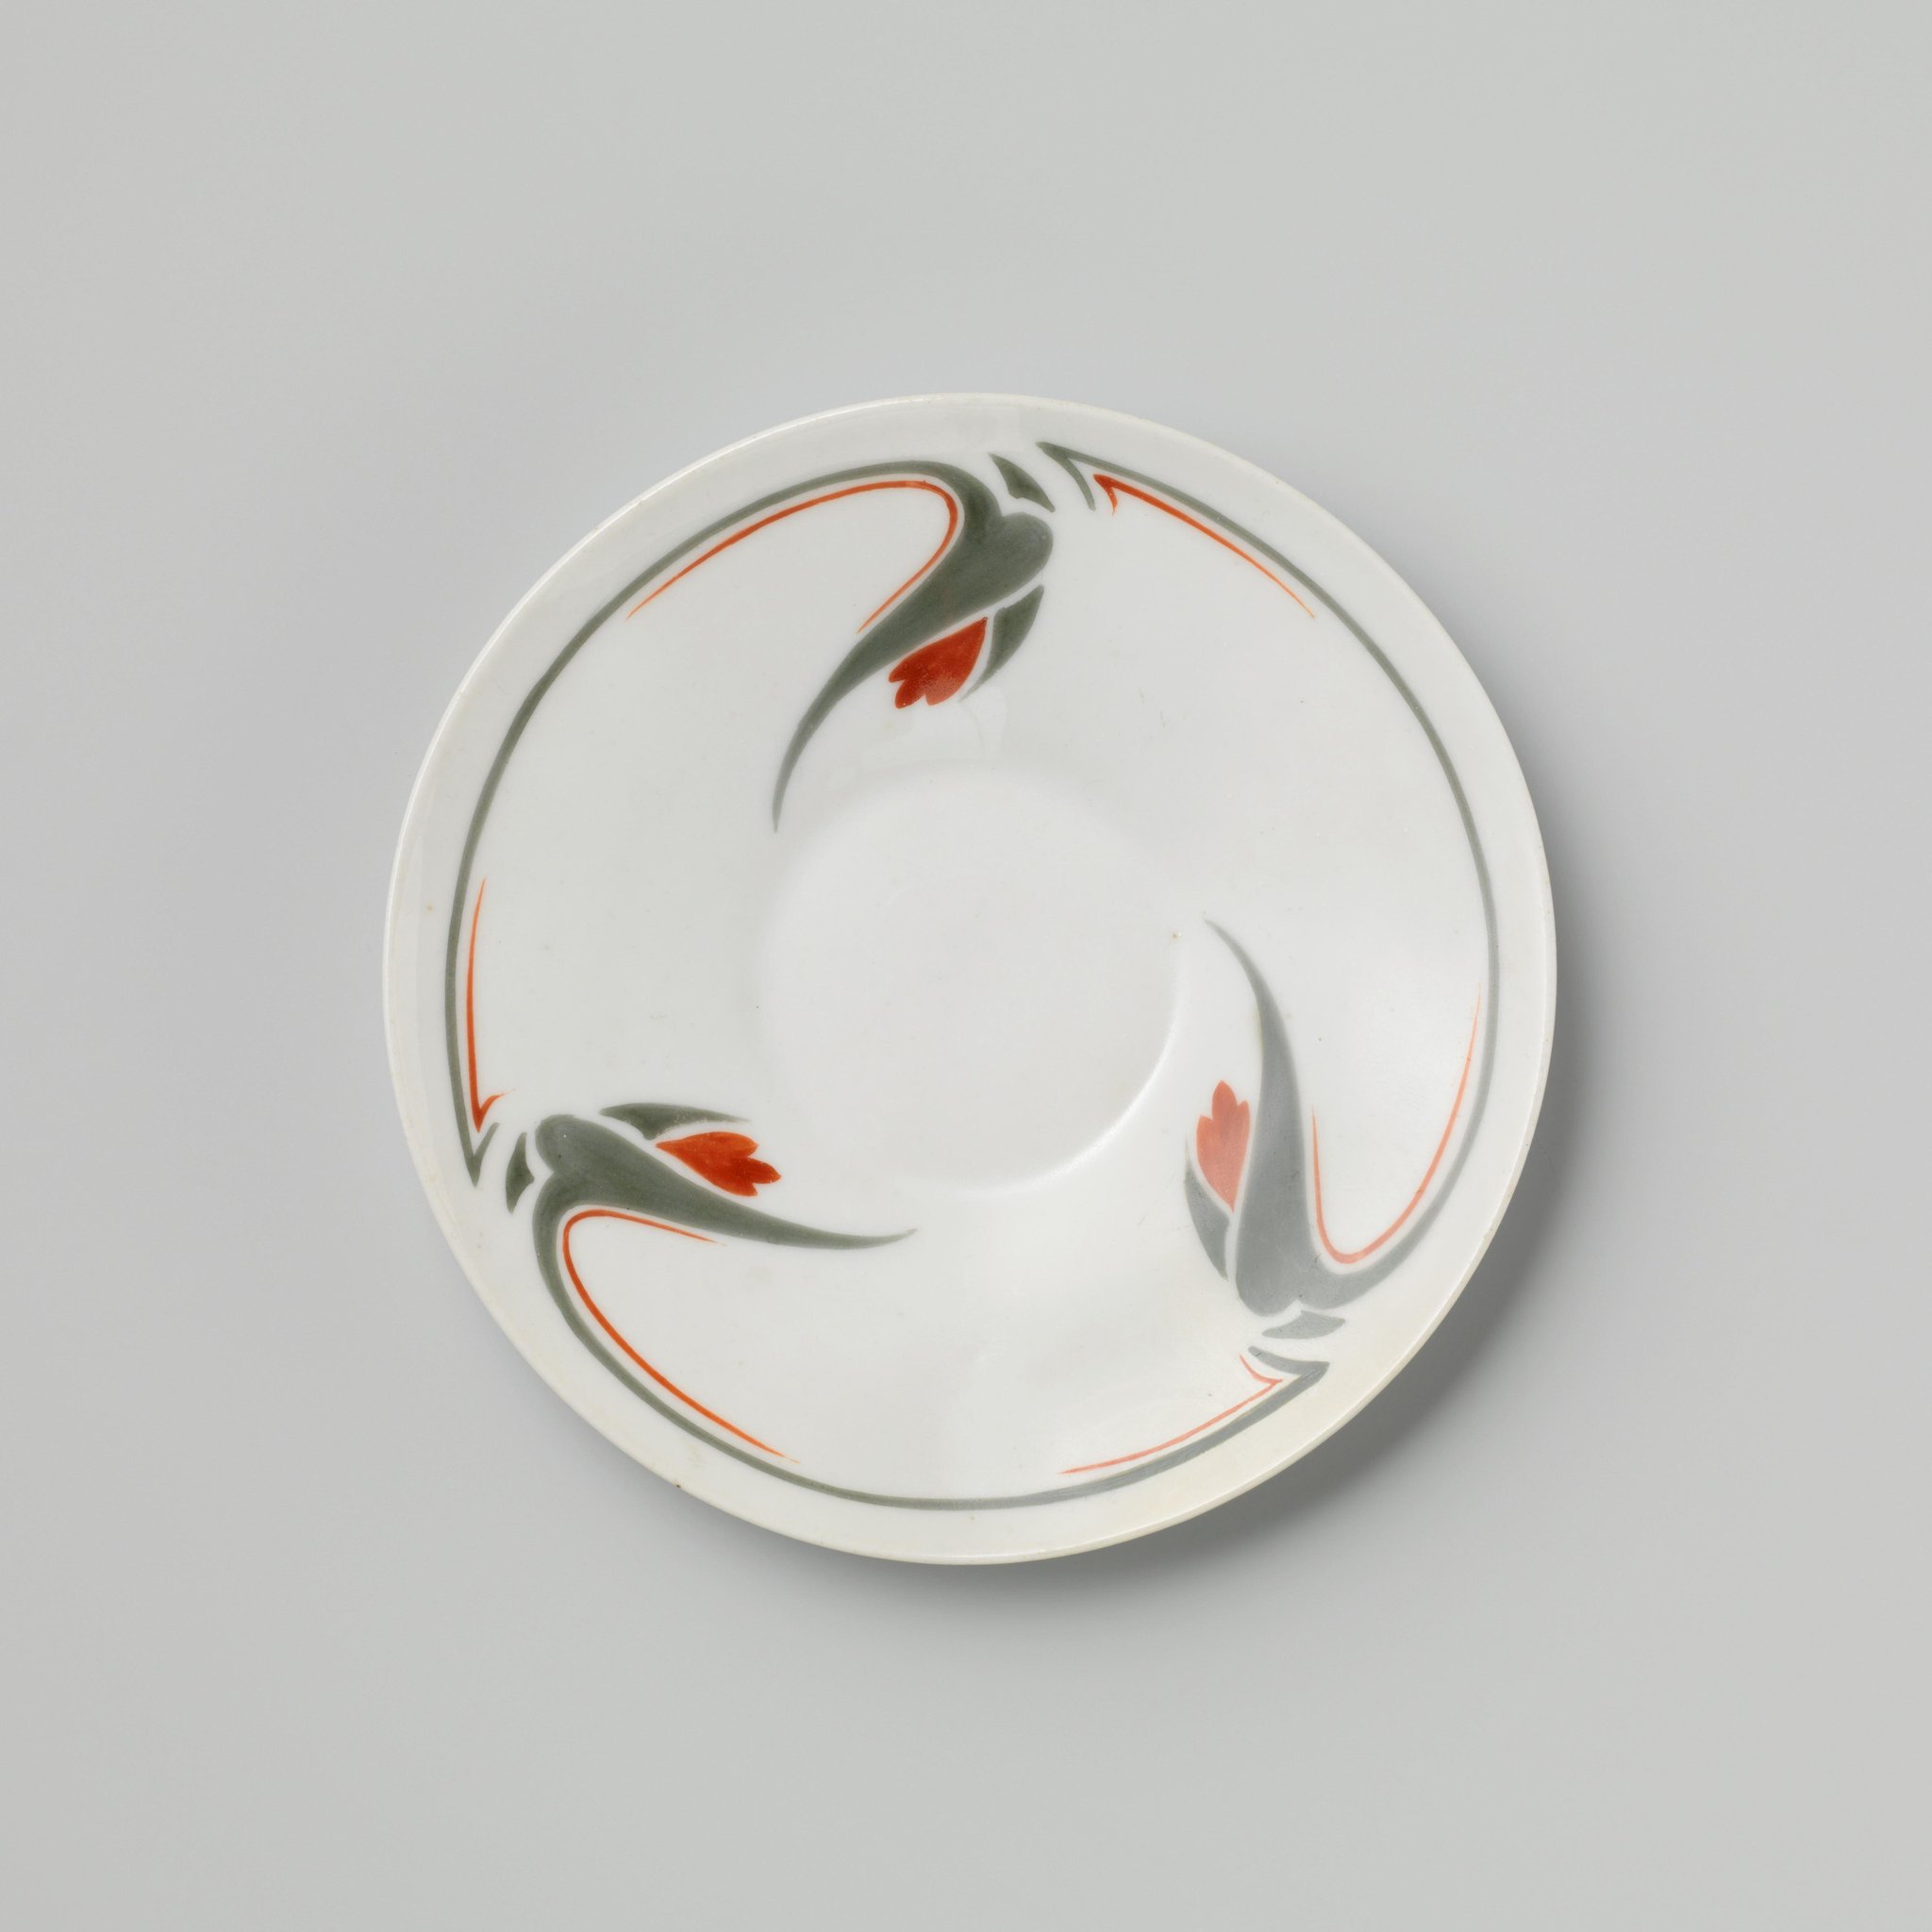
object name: tea service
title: Saucer with stylized floral motifs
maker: maurice dufrêne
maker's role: designer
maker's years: 1876-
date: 1900-1905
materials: glaze, paint, porcelain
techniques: firing, forming, turning, vitrification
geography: paris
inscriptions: mark: ‘LE PARTHÉNON/ PARIS’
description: Schotel van porselein, beschilderd op het glazuur in groen en rood. Op de wand gestileerde bloemtakken. De buitenwand met een dunne band in reliëf. Gemerkt op de onderzijde met 'LE PARTHÉNON/ PARIS'. Naar ontwerp van Maurice Dufrêne, vervaardigd voor La Maison Moderne, mogelijk door Le Parthénon, Parijs.